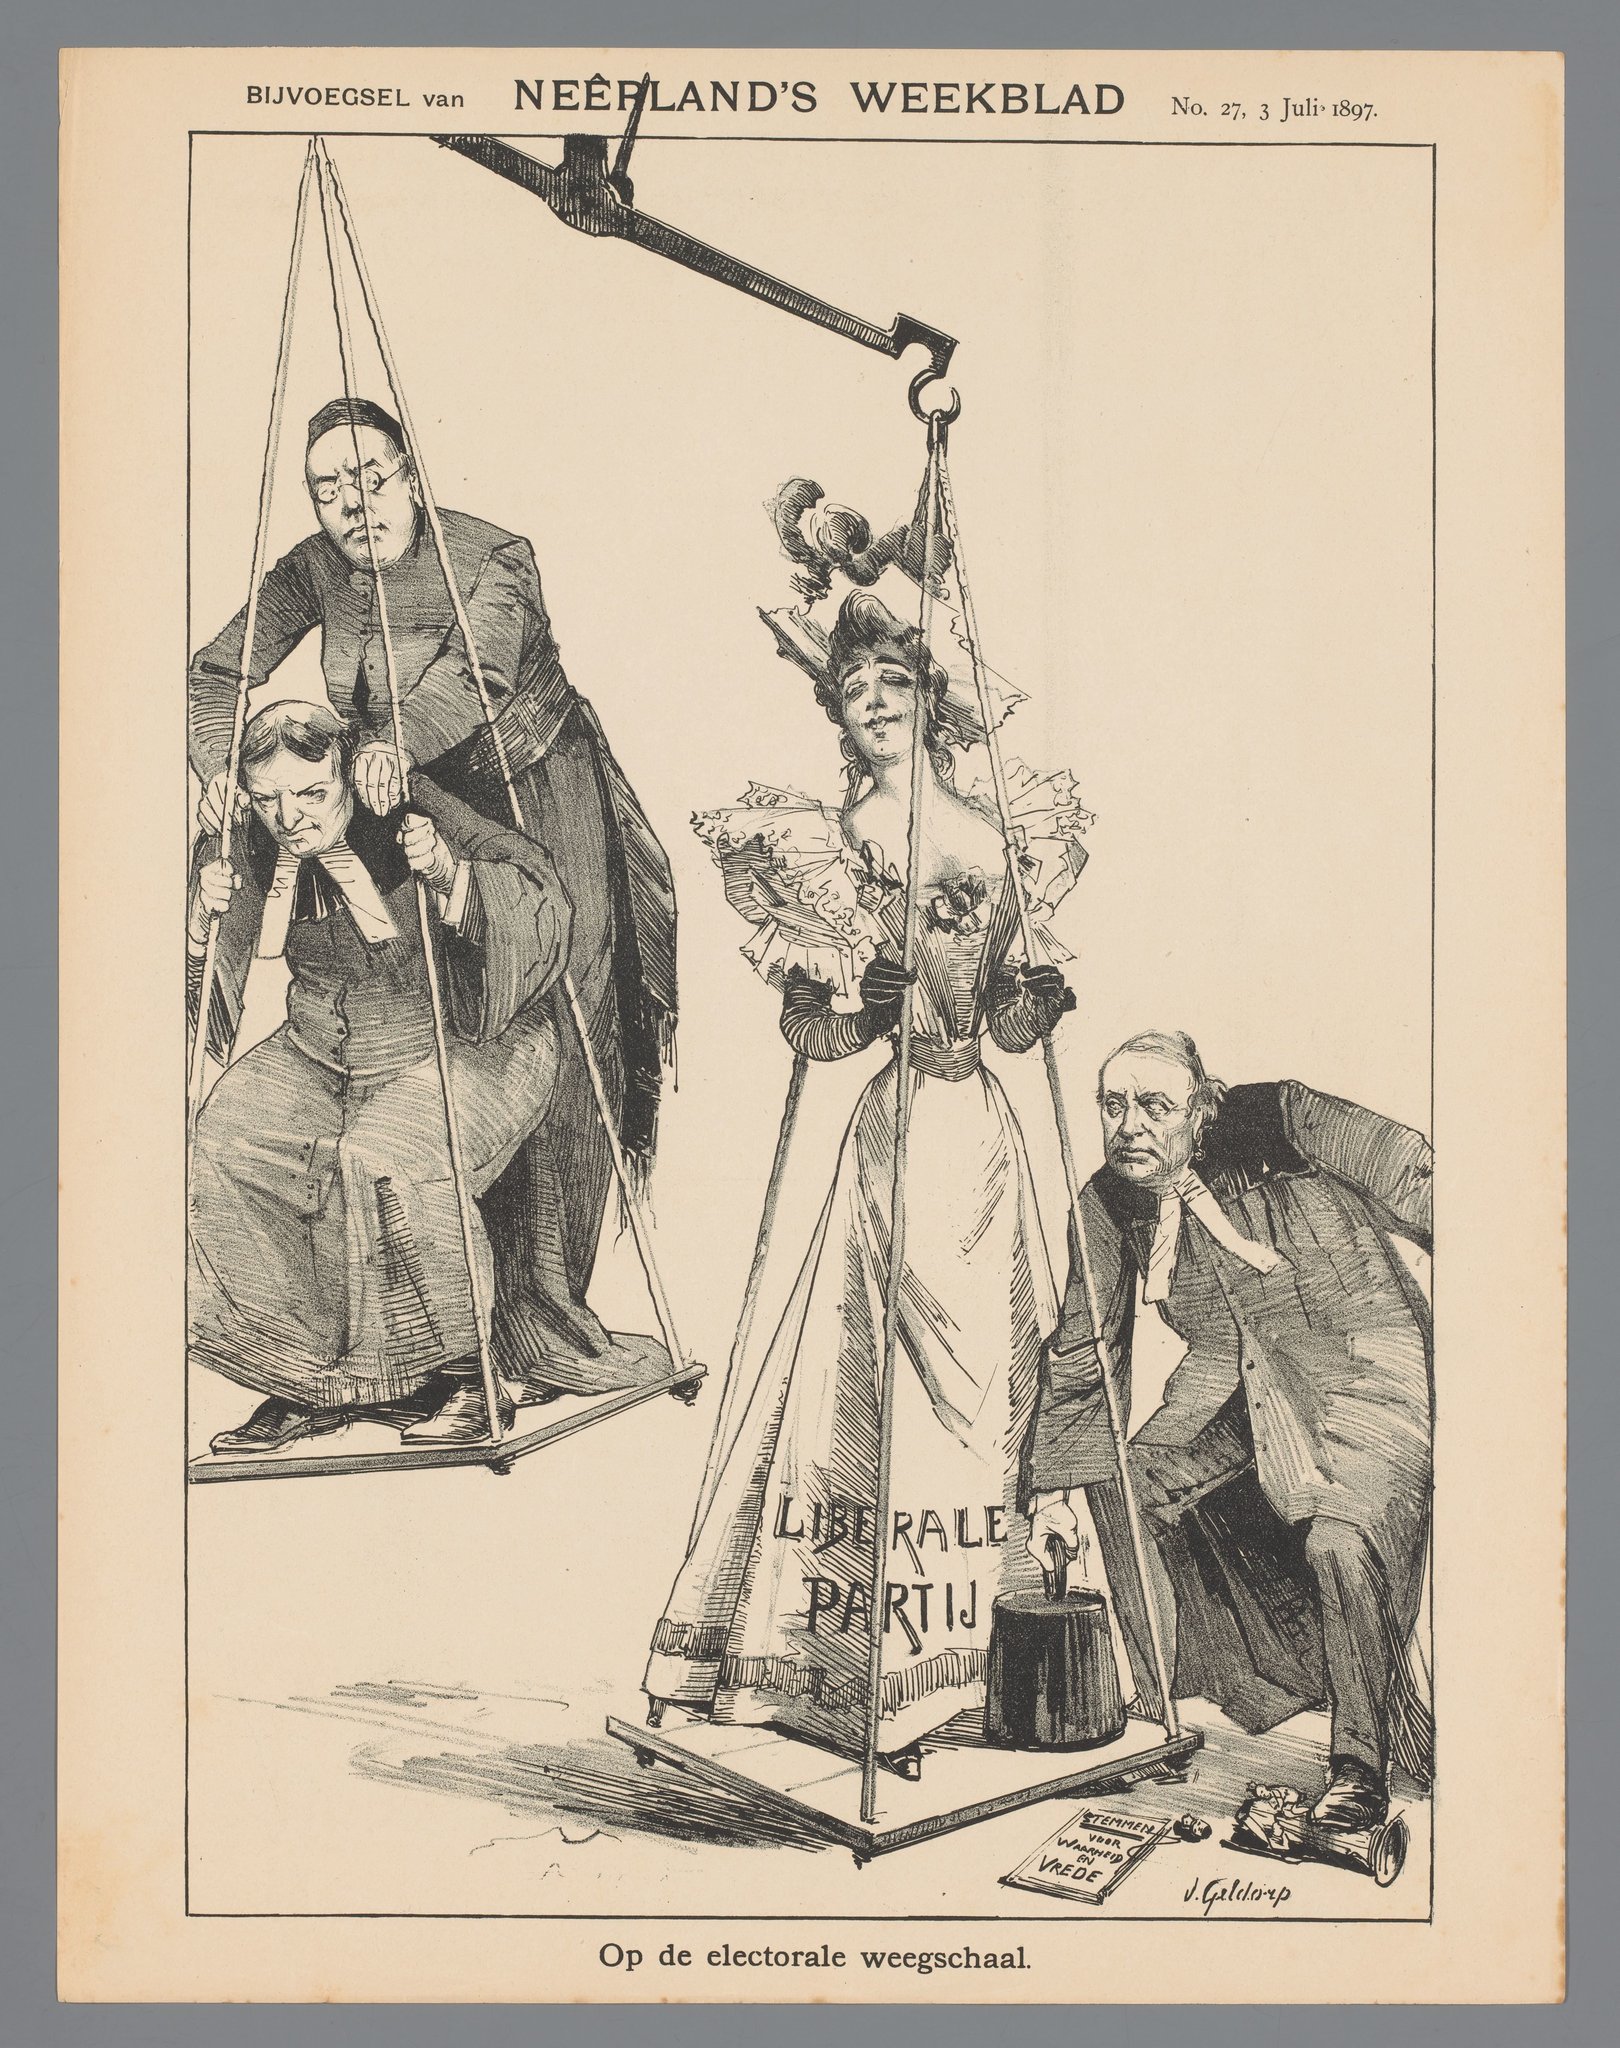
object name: cartoon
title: Op de electorale weegschaal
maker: petrus van geldorp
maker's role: draughtsman, print maker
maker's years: 1872-1939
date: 1897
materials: paper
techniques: lithograph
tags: abraham kuyper, rome, priest, herman johannes aloysius maria schaepman, scales, political caricatures and satires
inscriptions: date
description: Prent uit het bijvoegsel van: Neêrland’s Weekblad, nr. 27, 3 juli 1897.